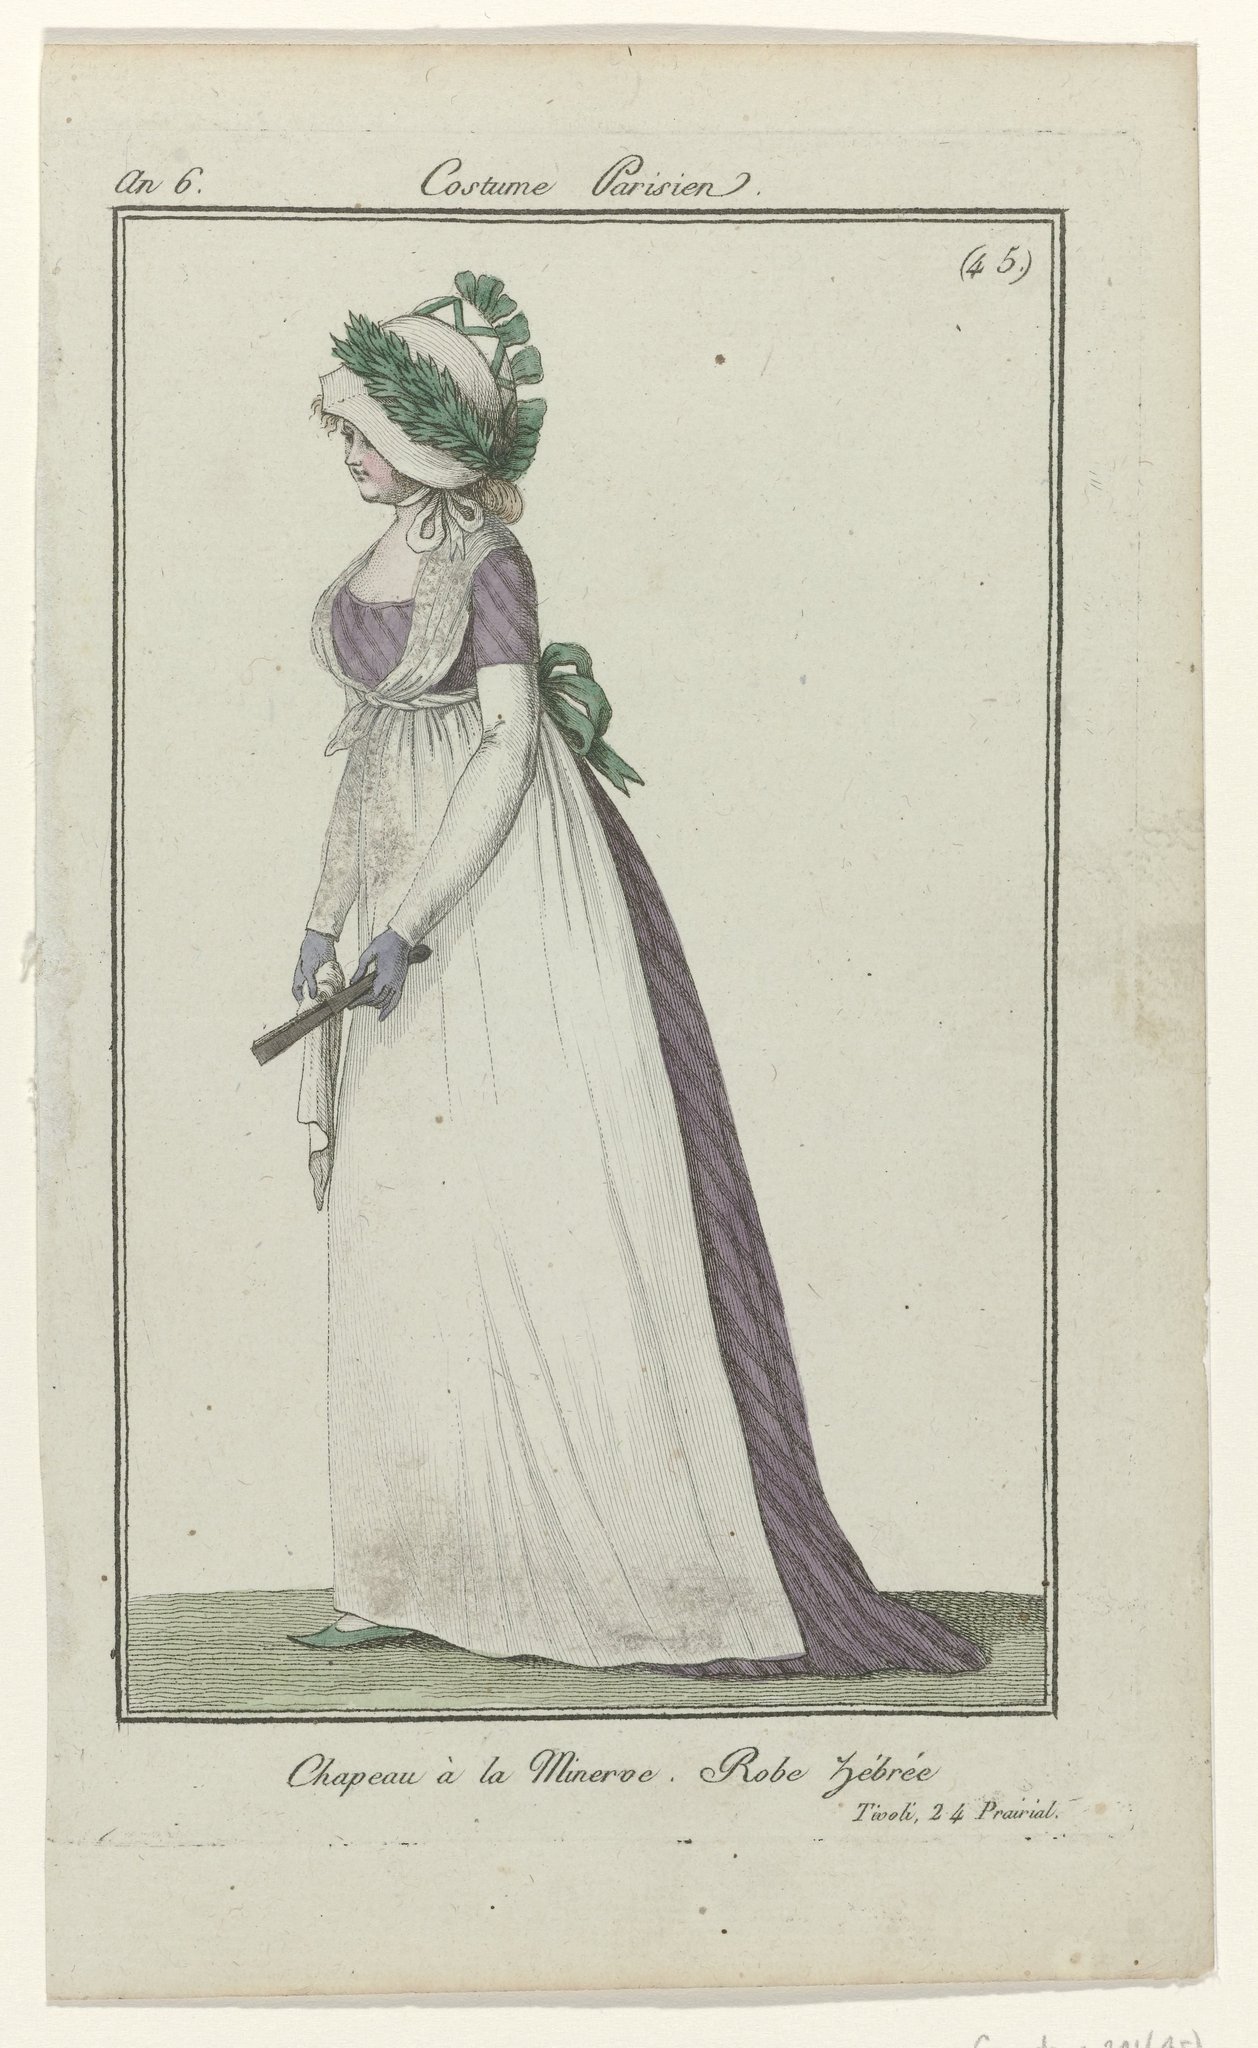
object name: fashion print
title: Journal des Dames et des Modes, Costume Parisien, 23 juin 1798, An 6, (45) : Chapeau à la Minerv (...)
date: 1798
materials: paper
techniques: engraving, hand coloring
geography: paris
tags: handkerchief (+ women's clothes), fashion plates, head-gear: hat (+ women's clothes), gloves, mittens, etc. (+ women's clothes), dress, gown (+ women's clothes), fan (+ women's clothes), apron (+ women's clothes), piece of clothing covering the breast or décolleté (fichu) (+ women's clothes)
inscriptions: caption: ‘Tivoli, 24 Prairial.’, caption: ‘Chapeau à la Minerve. Robe zébrée.’, title: ‘Costume Parisien.’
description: 'Chapeau à la Minerve'. Gestreepte japon met sleep: 'Robe Zébrée'. Fichu en een lang schort, dat op de rug is vastgestrikt(?). Verder accessoires: handschoenen, zakdoek, waaier, platte schoen met puntige neus. Volgens het onderschrift is deze voorstelling naar het leven getekend in 'Tivoli'. De prent maakt deel uit van het modetijdschrift Journal des Dames et des Modes, uitgegeven door Sellèque, Parijs, 1797-1839.